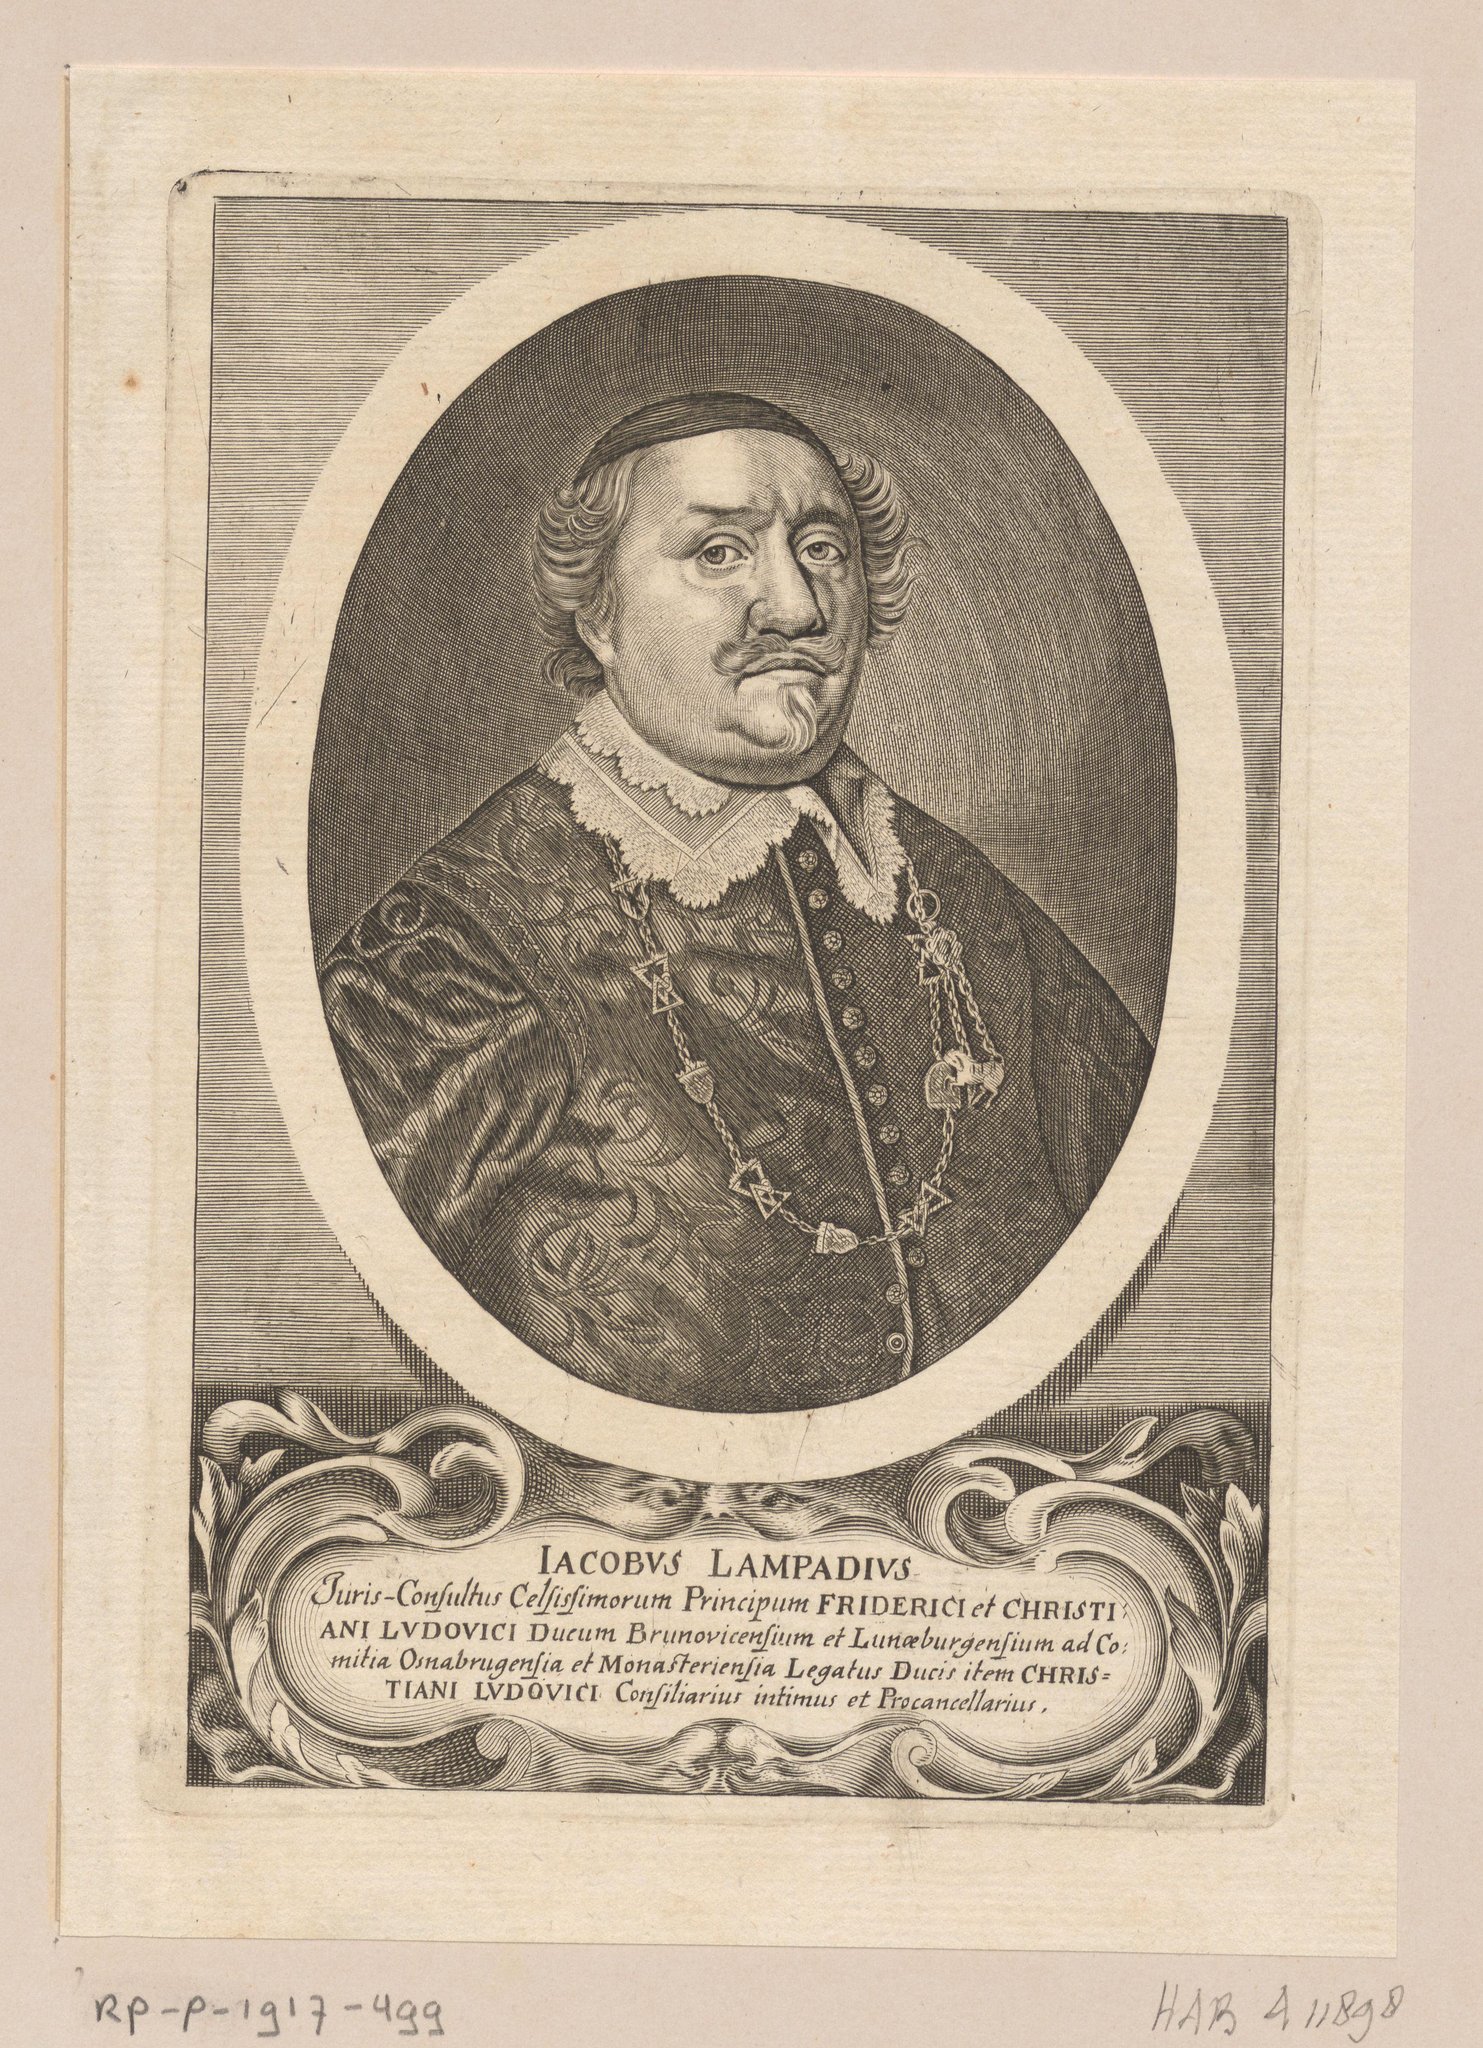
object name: book illustration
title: Portret van Jakob Lampadius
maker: Anonymous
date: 1652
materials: paper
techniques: engraving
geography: germany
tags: rocaille ornament, historical persons, ornament ~ cartouche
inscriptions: collector's mark: Lugt 2228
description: Prent waarschijnlijk uit: Theatrum Europaeum (...). 1e druk. Frankfurt: erven Matthaus Merian, 1652, dl. 6.